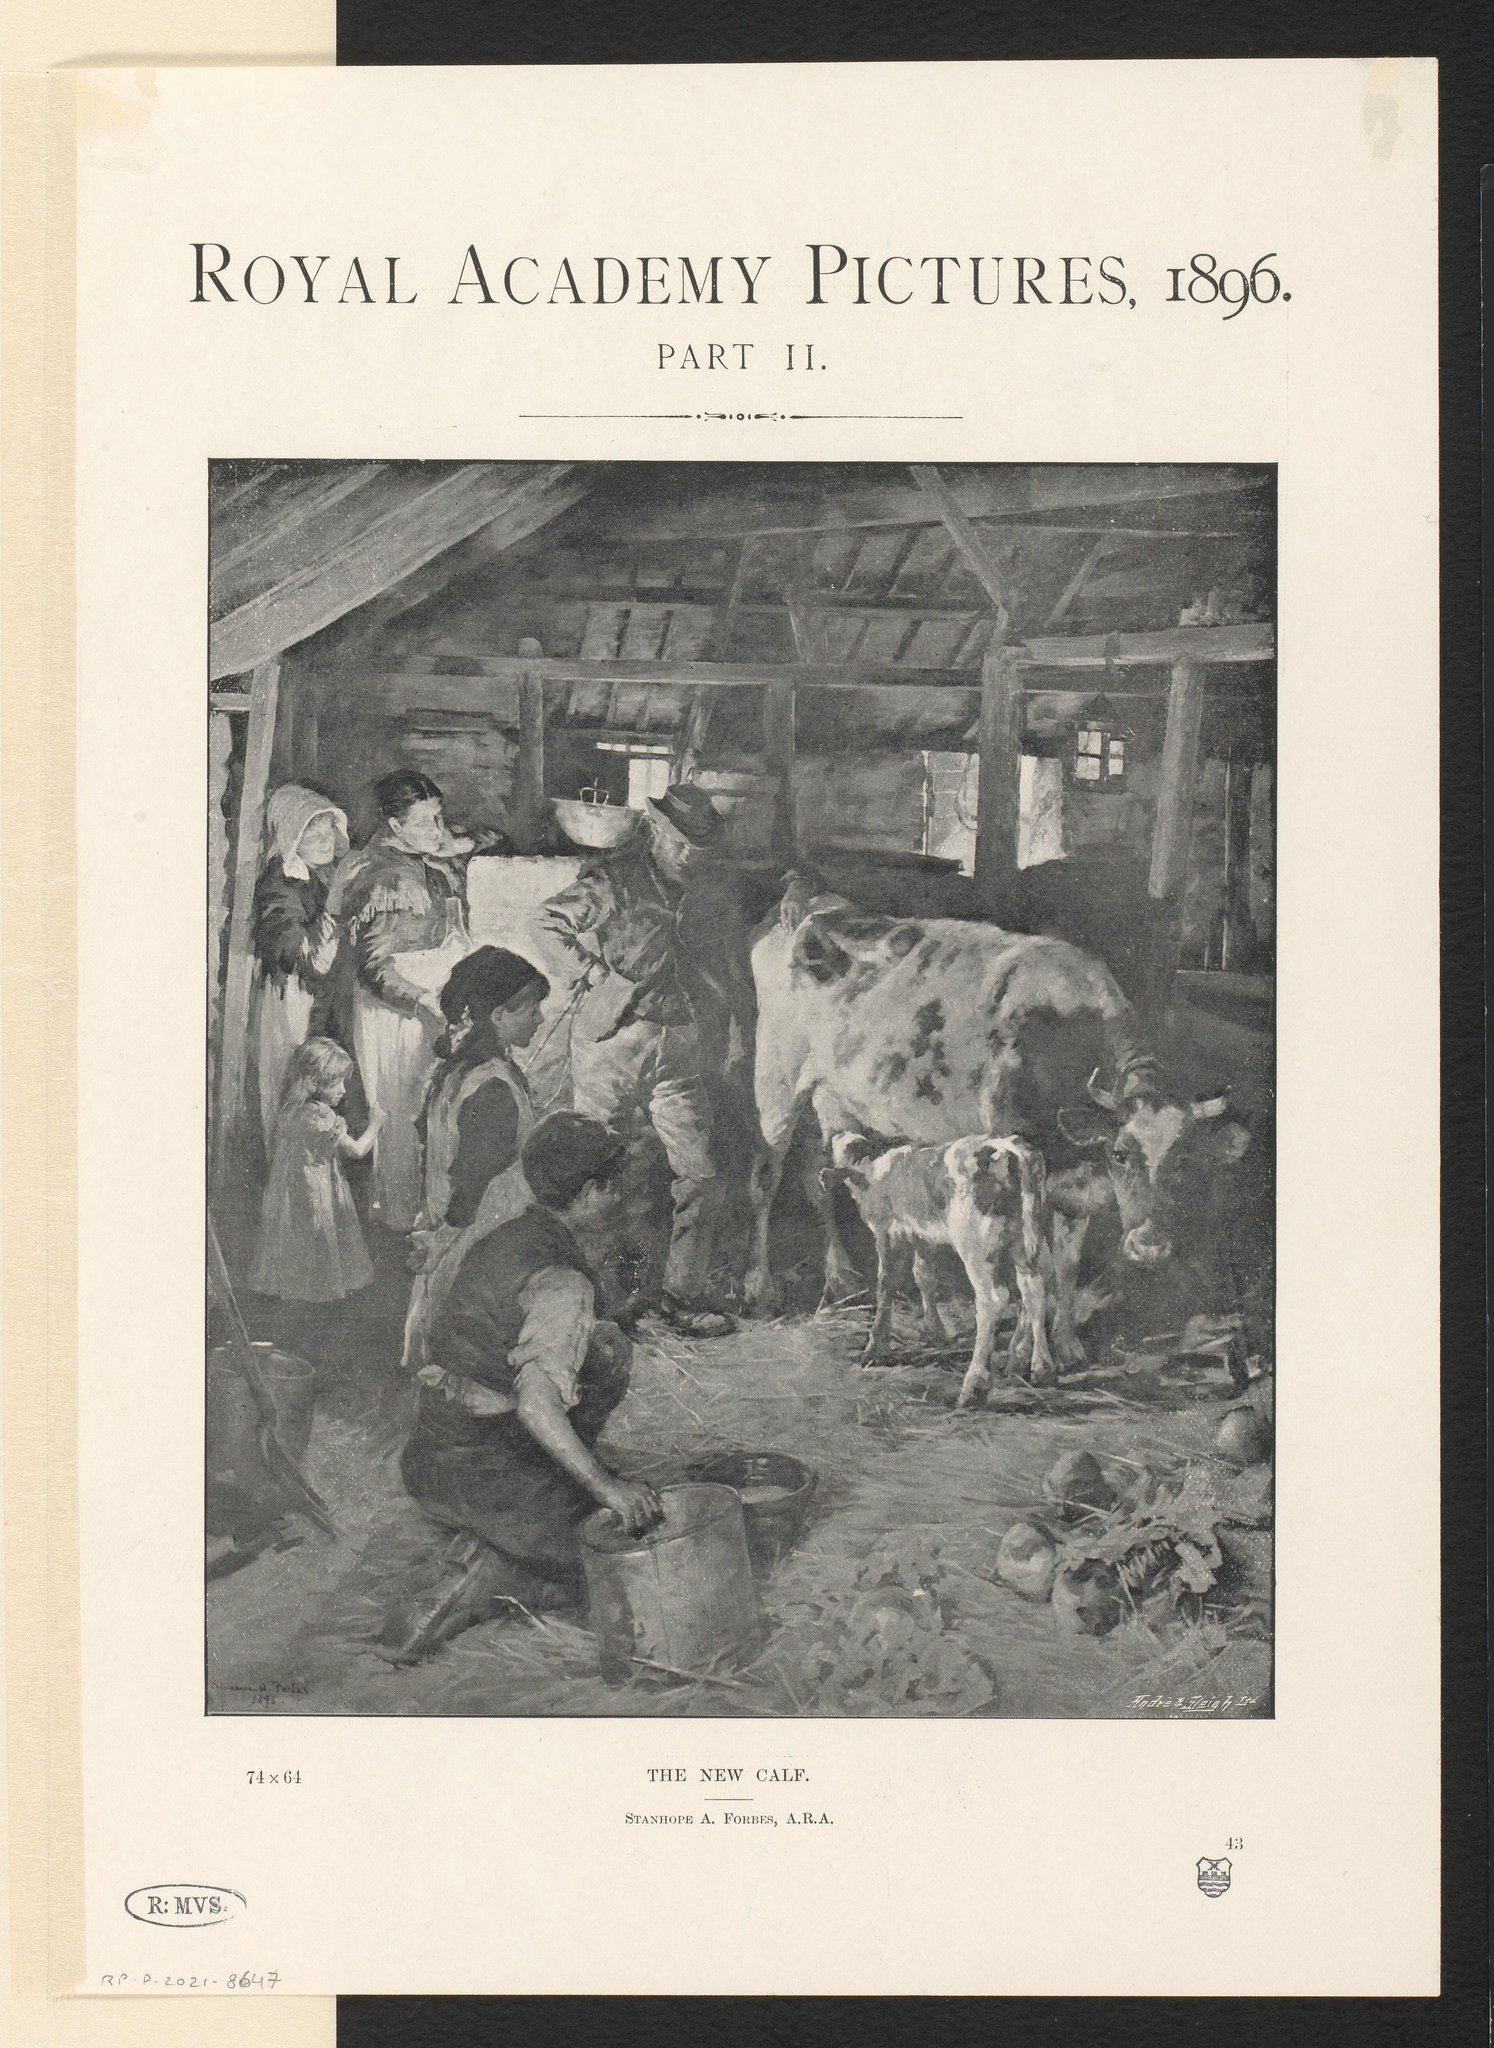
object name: photomechanical print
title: The New Calf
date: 1896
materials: paper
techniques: autotype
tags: farmers, calf, farm (building)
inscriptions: collector's mark: Lugt 2760, collector's mark: Lugt 2228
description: Prent uit: Royal Academy Picture 1896. Being the Royal Academy Supplement of "The Magazine of Art". Londen, Parijs en Melbourne: Cassell and Company, 1896.